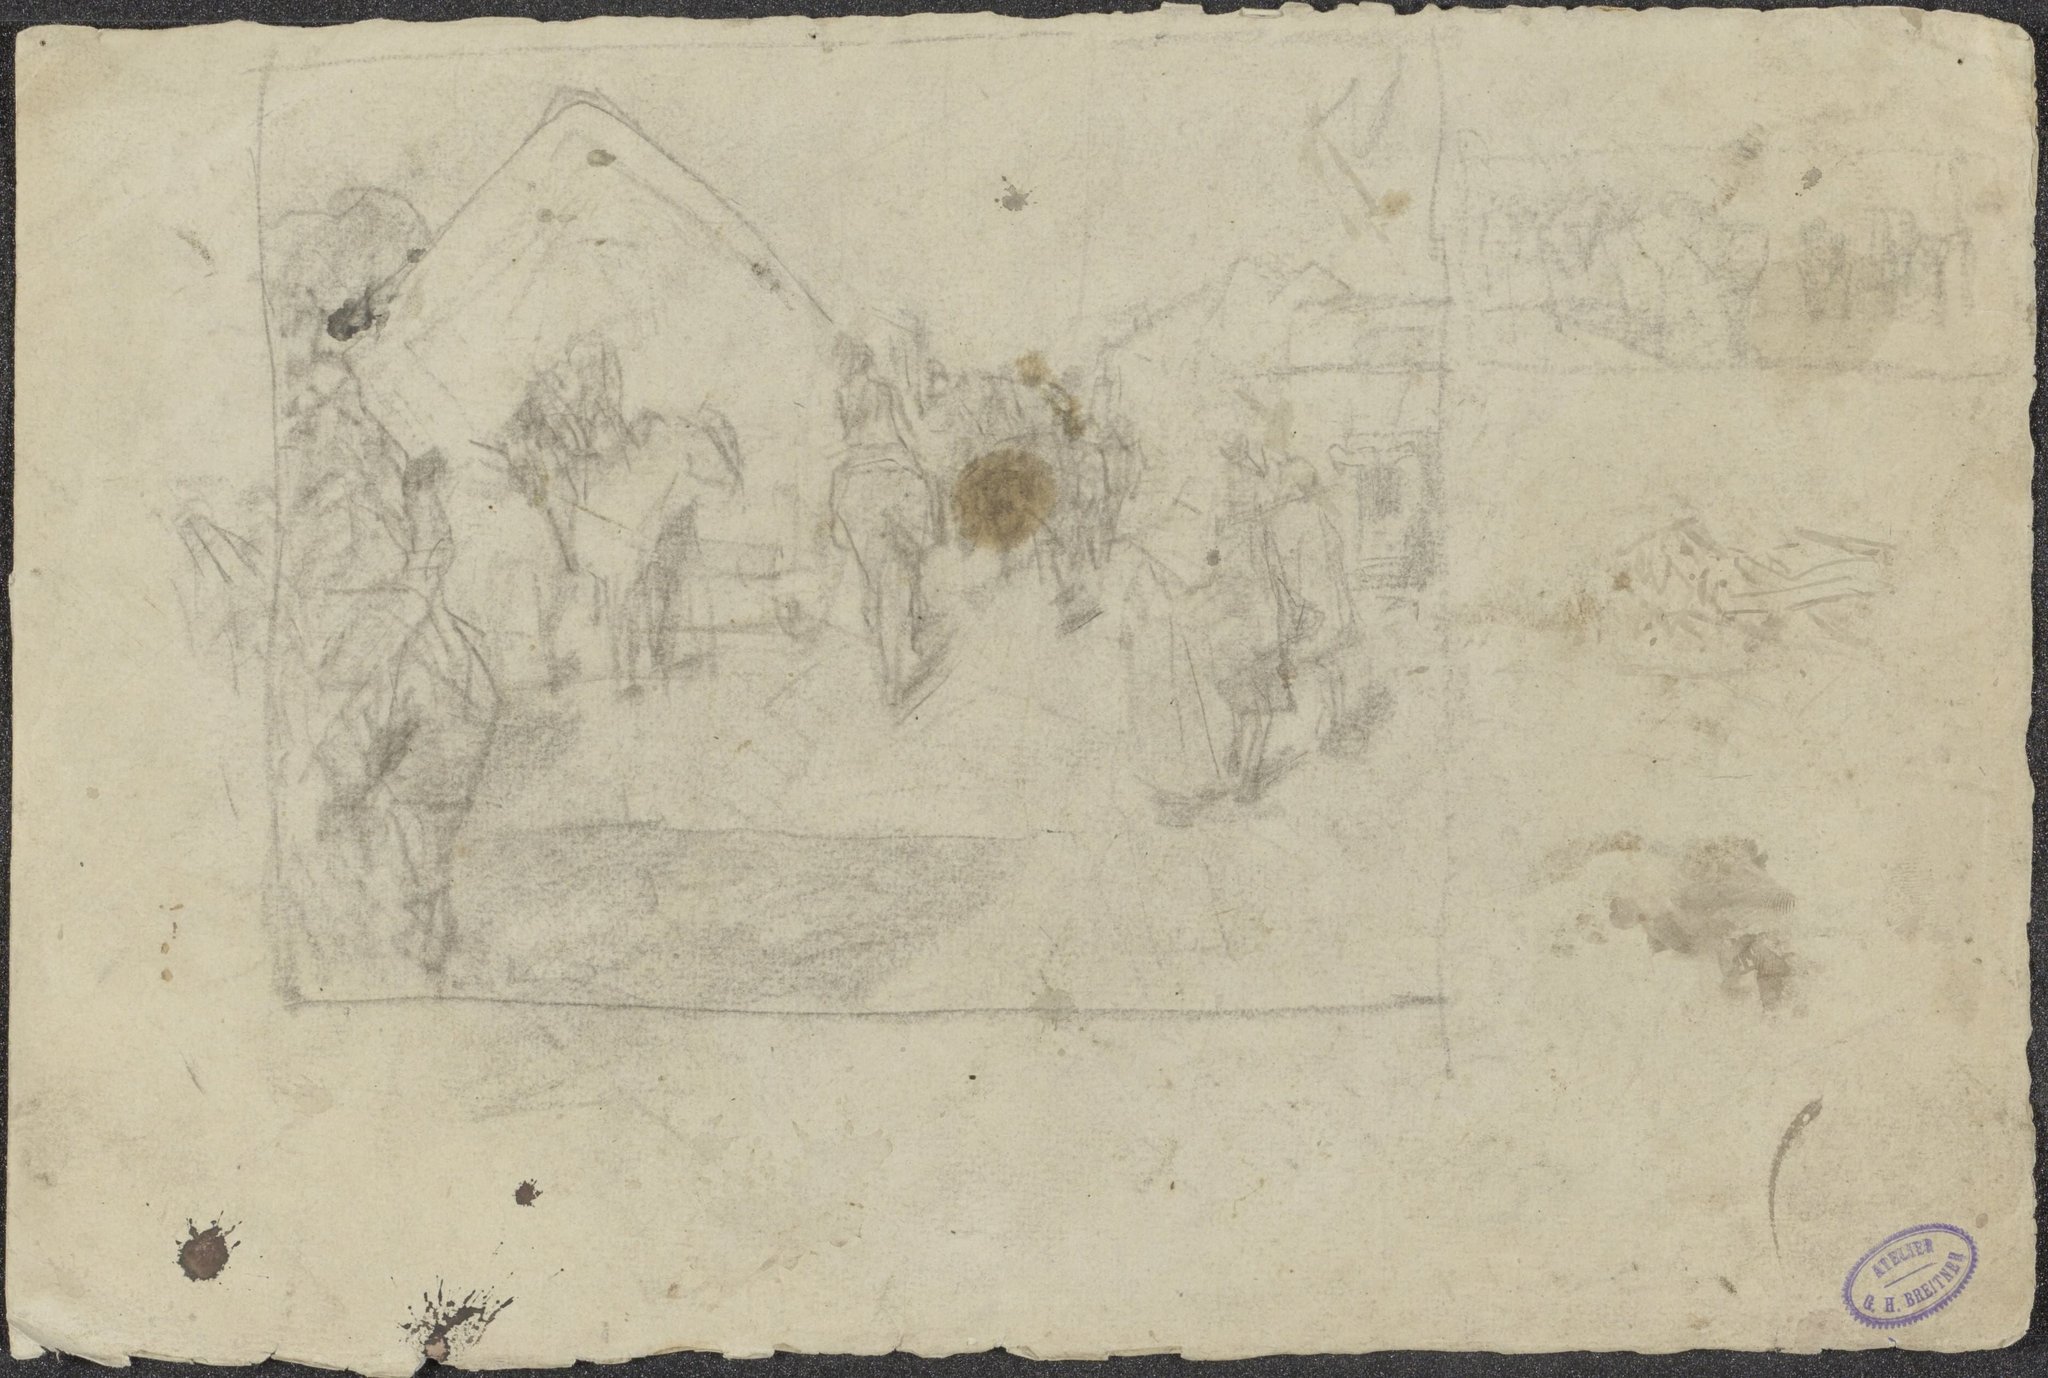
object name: drawing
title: Cavaleristen op een dorpsweg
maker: george hendrik breitner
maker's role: draughtsman, painter, print maker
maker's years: 1857-1923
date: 1873-1886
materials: chalk, paper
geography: netherlands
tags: village street, the soldier; the soldier's life (+ cavalry, horsemen)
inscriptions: workshop stamp: Lugt 291d